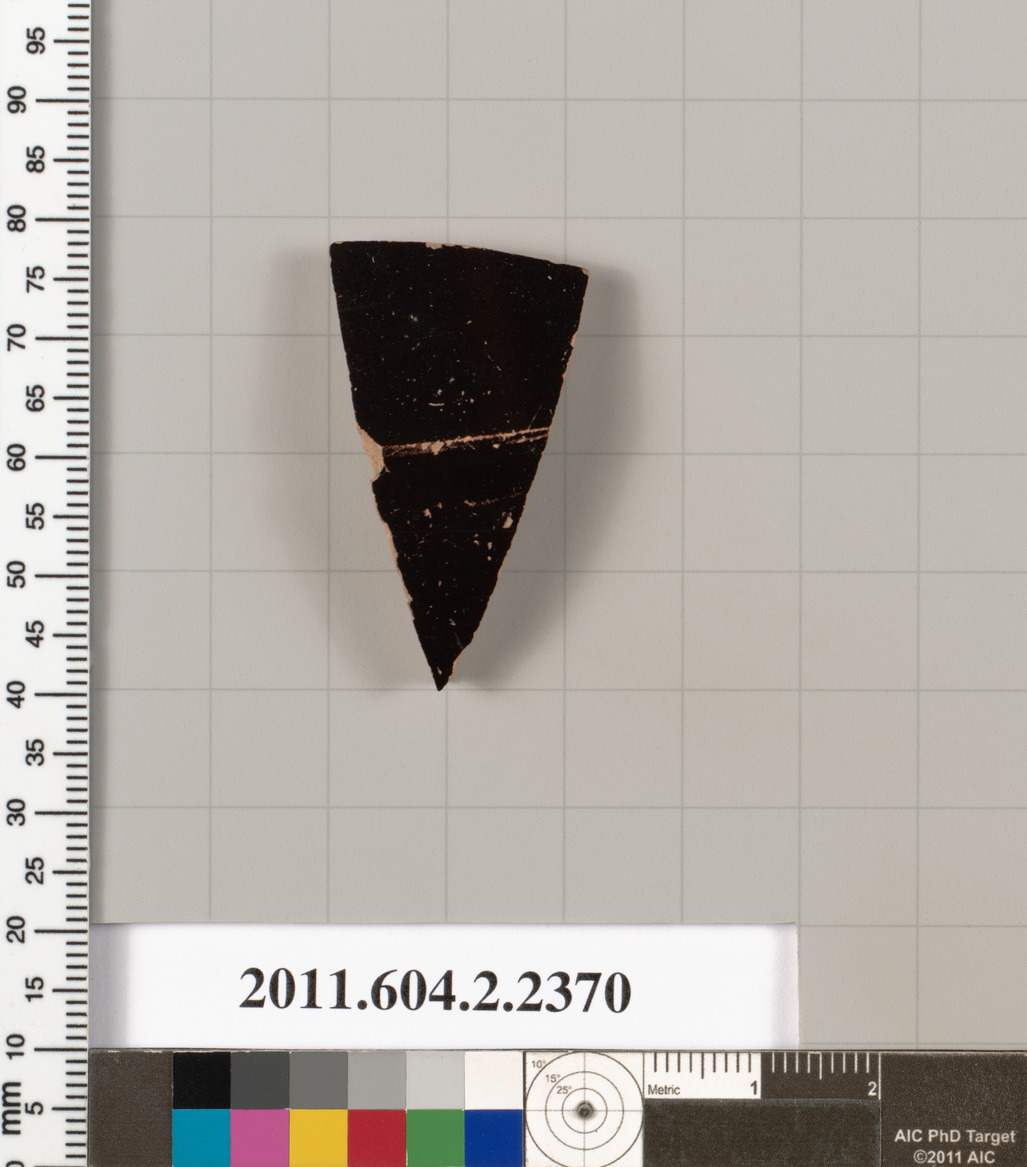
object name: kantharos fragment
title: Terracotta fragment of a kantharos (drinking cup with high handles)?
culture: greek, attic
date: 500-401 BCE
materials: terracotta